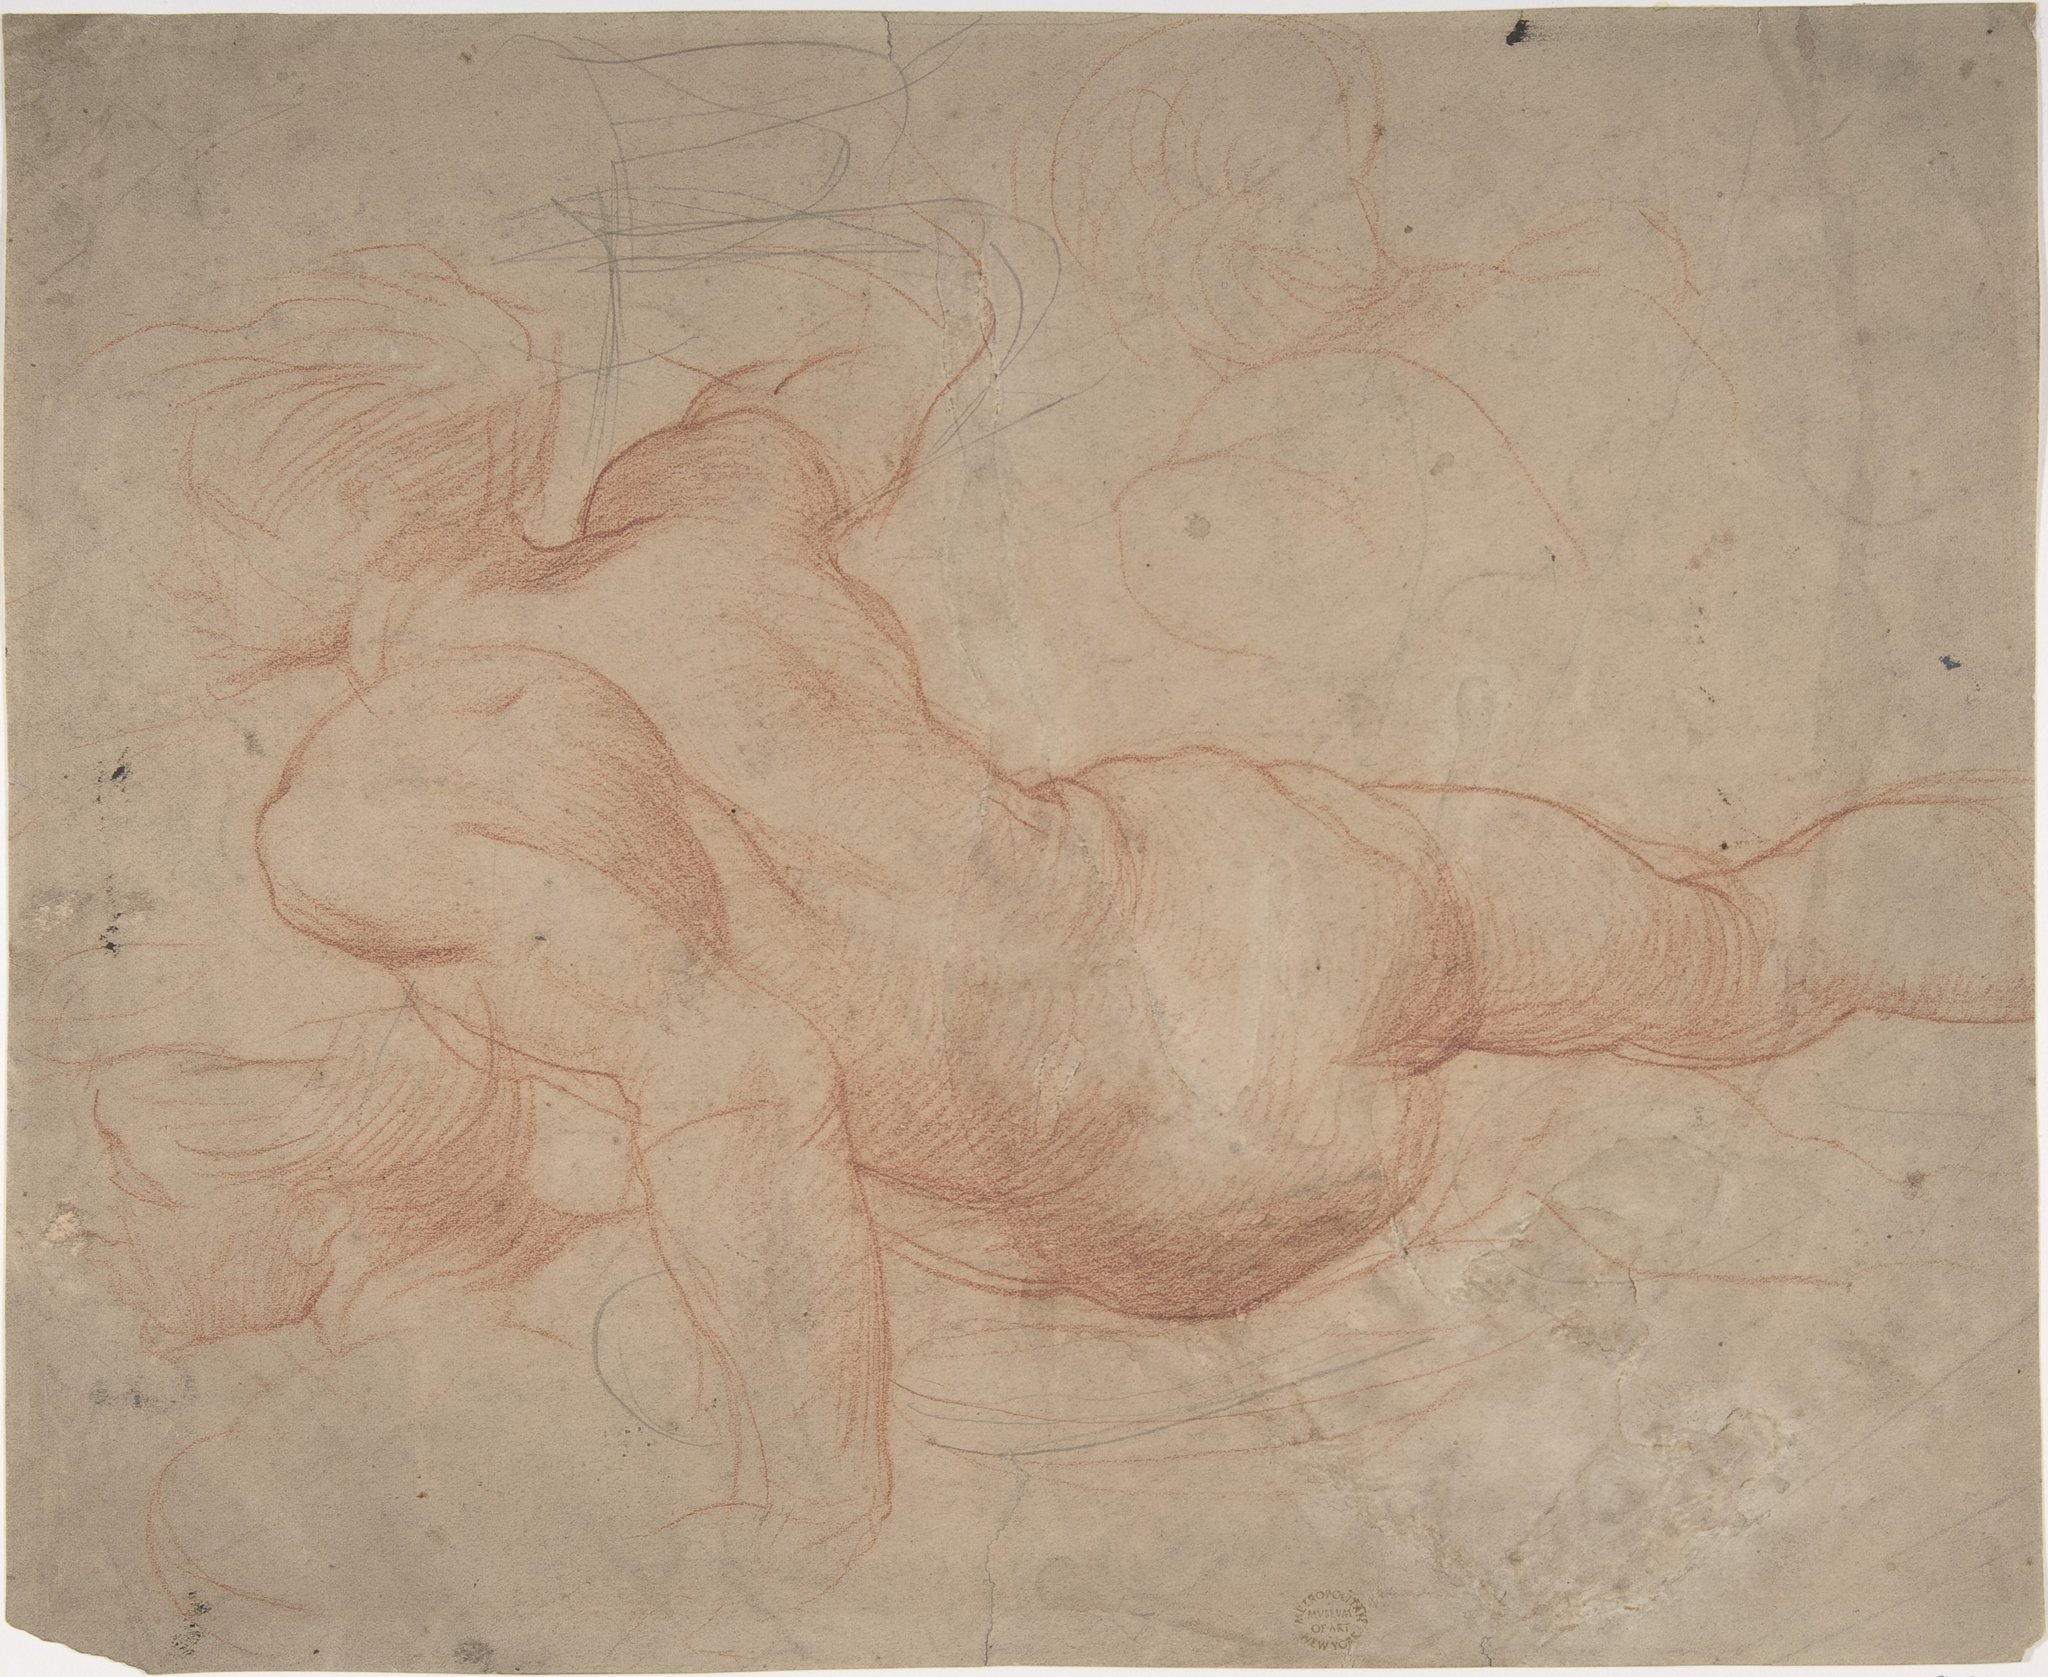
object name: drawing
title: Nude Figure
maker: alfred george stevens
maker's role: artist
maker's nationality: british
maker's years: 1817-1875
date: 1862-1865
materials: chalk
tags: male nudes